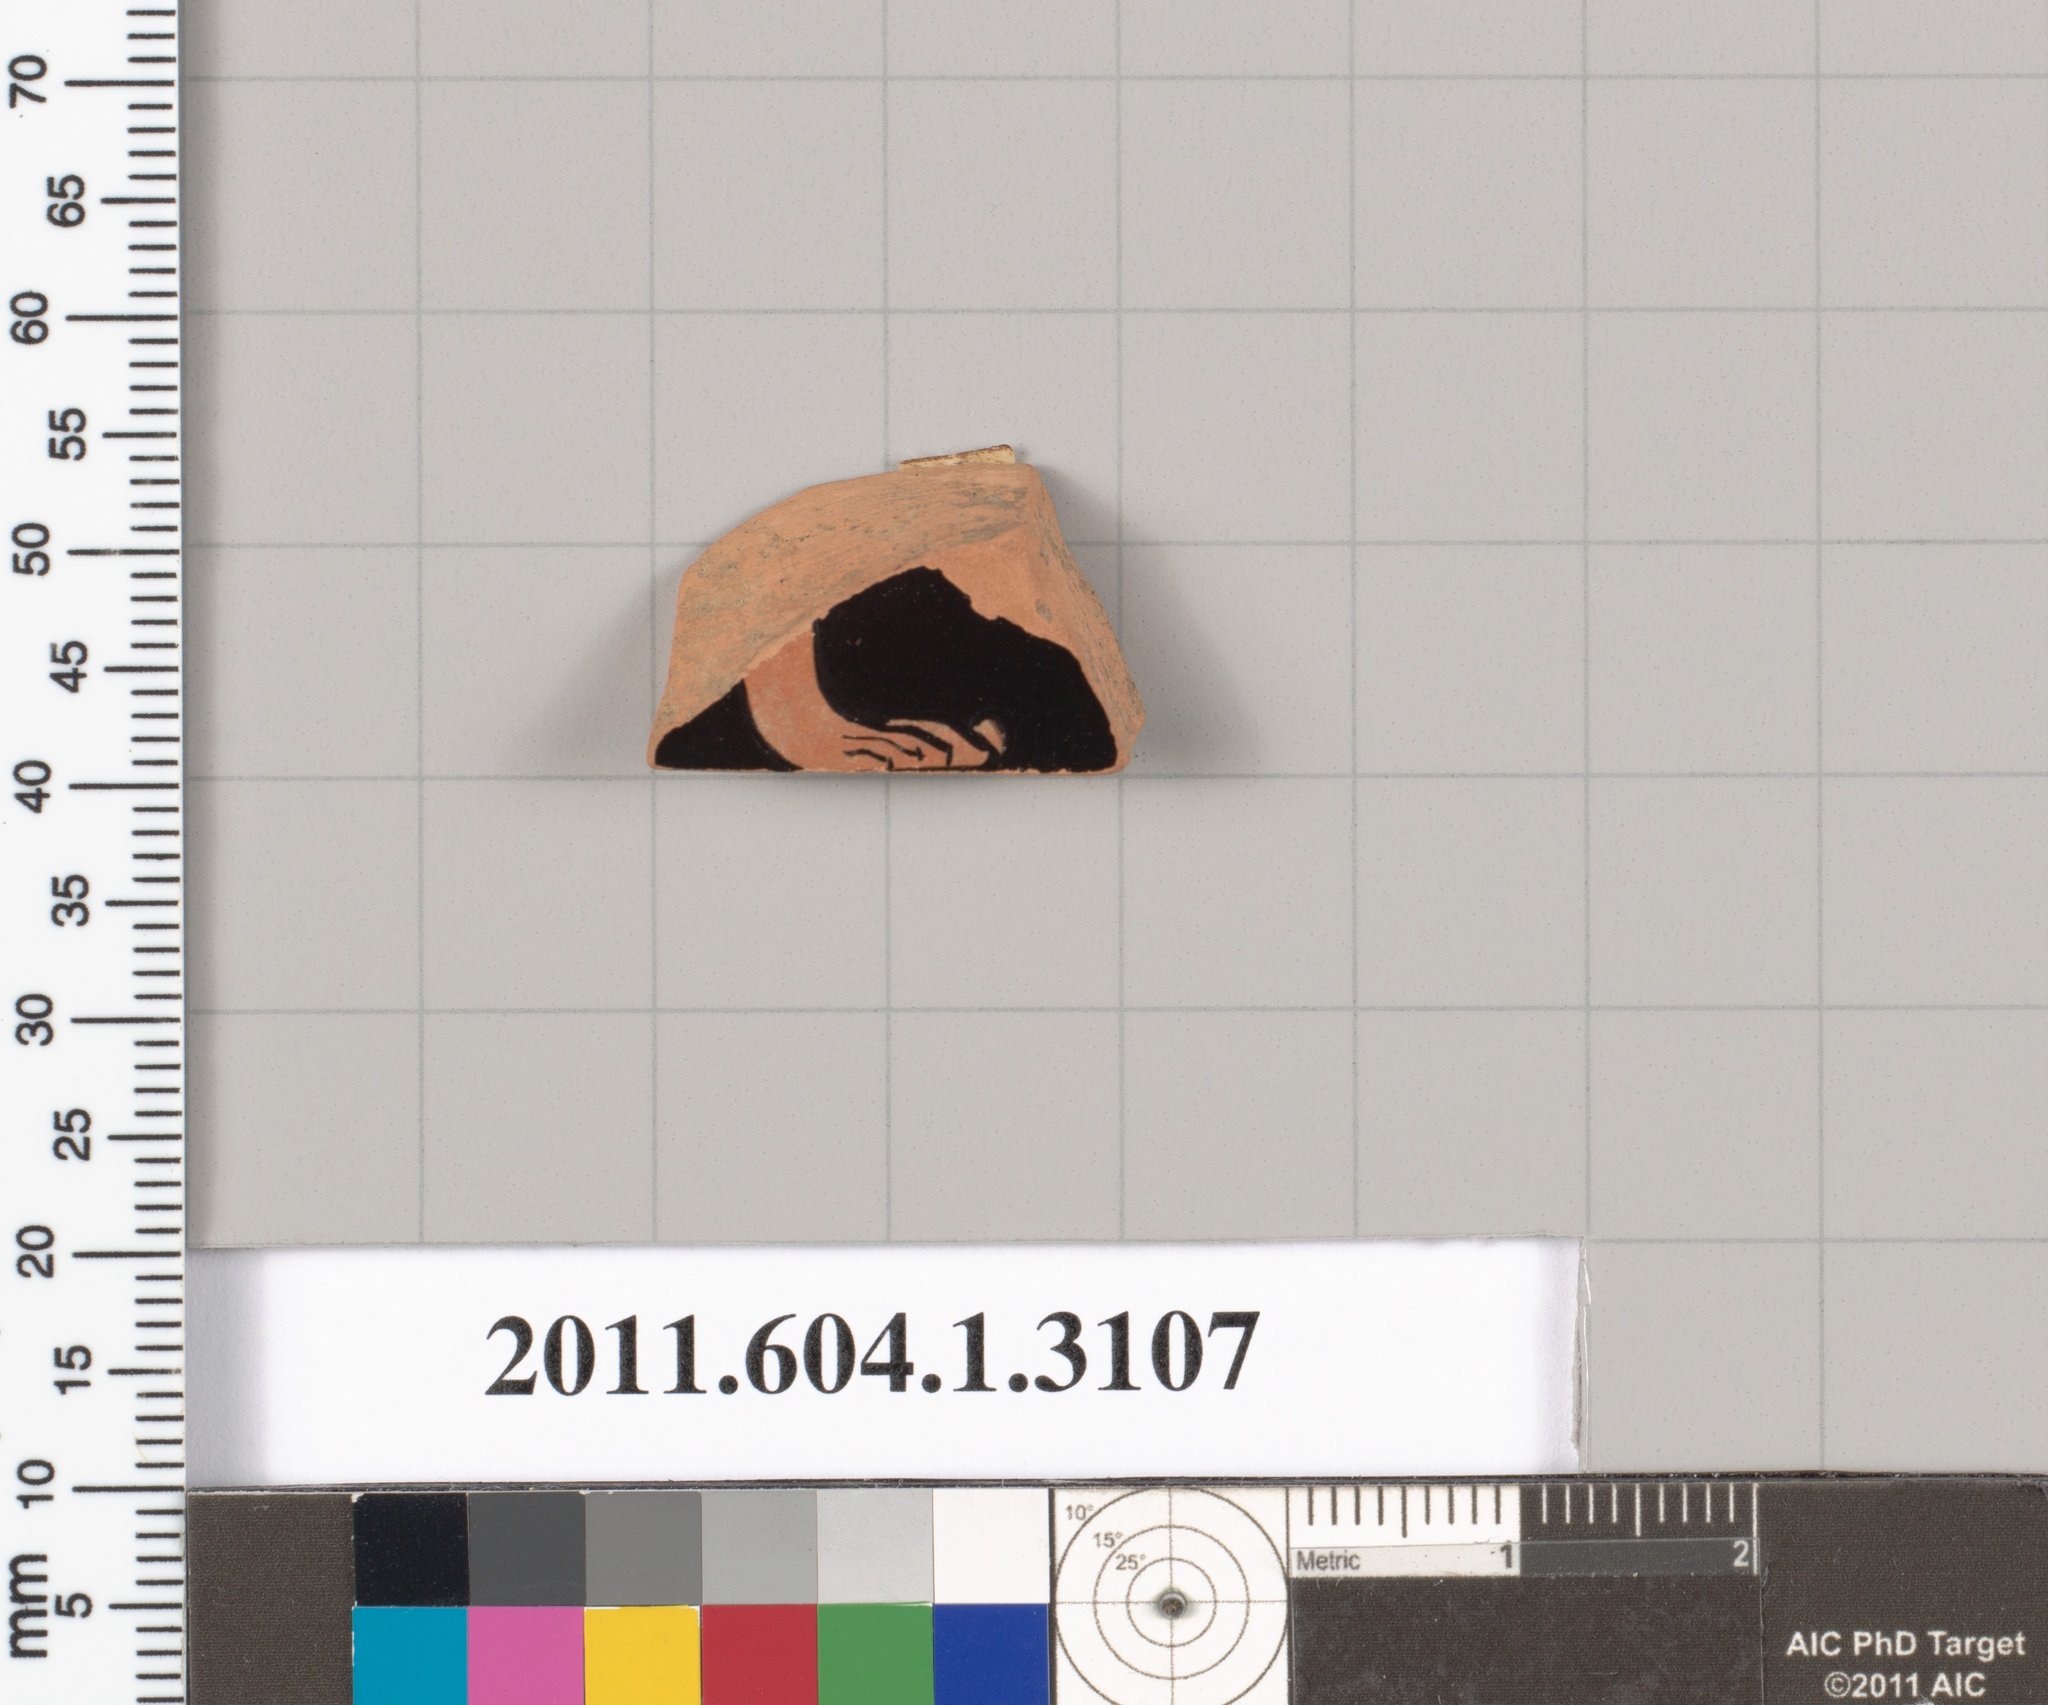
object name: kylix fragment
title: Terracotta fragment of a kylix (drinking cup)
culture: greek, attic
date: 534-501 BCE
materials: terracotta